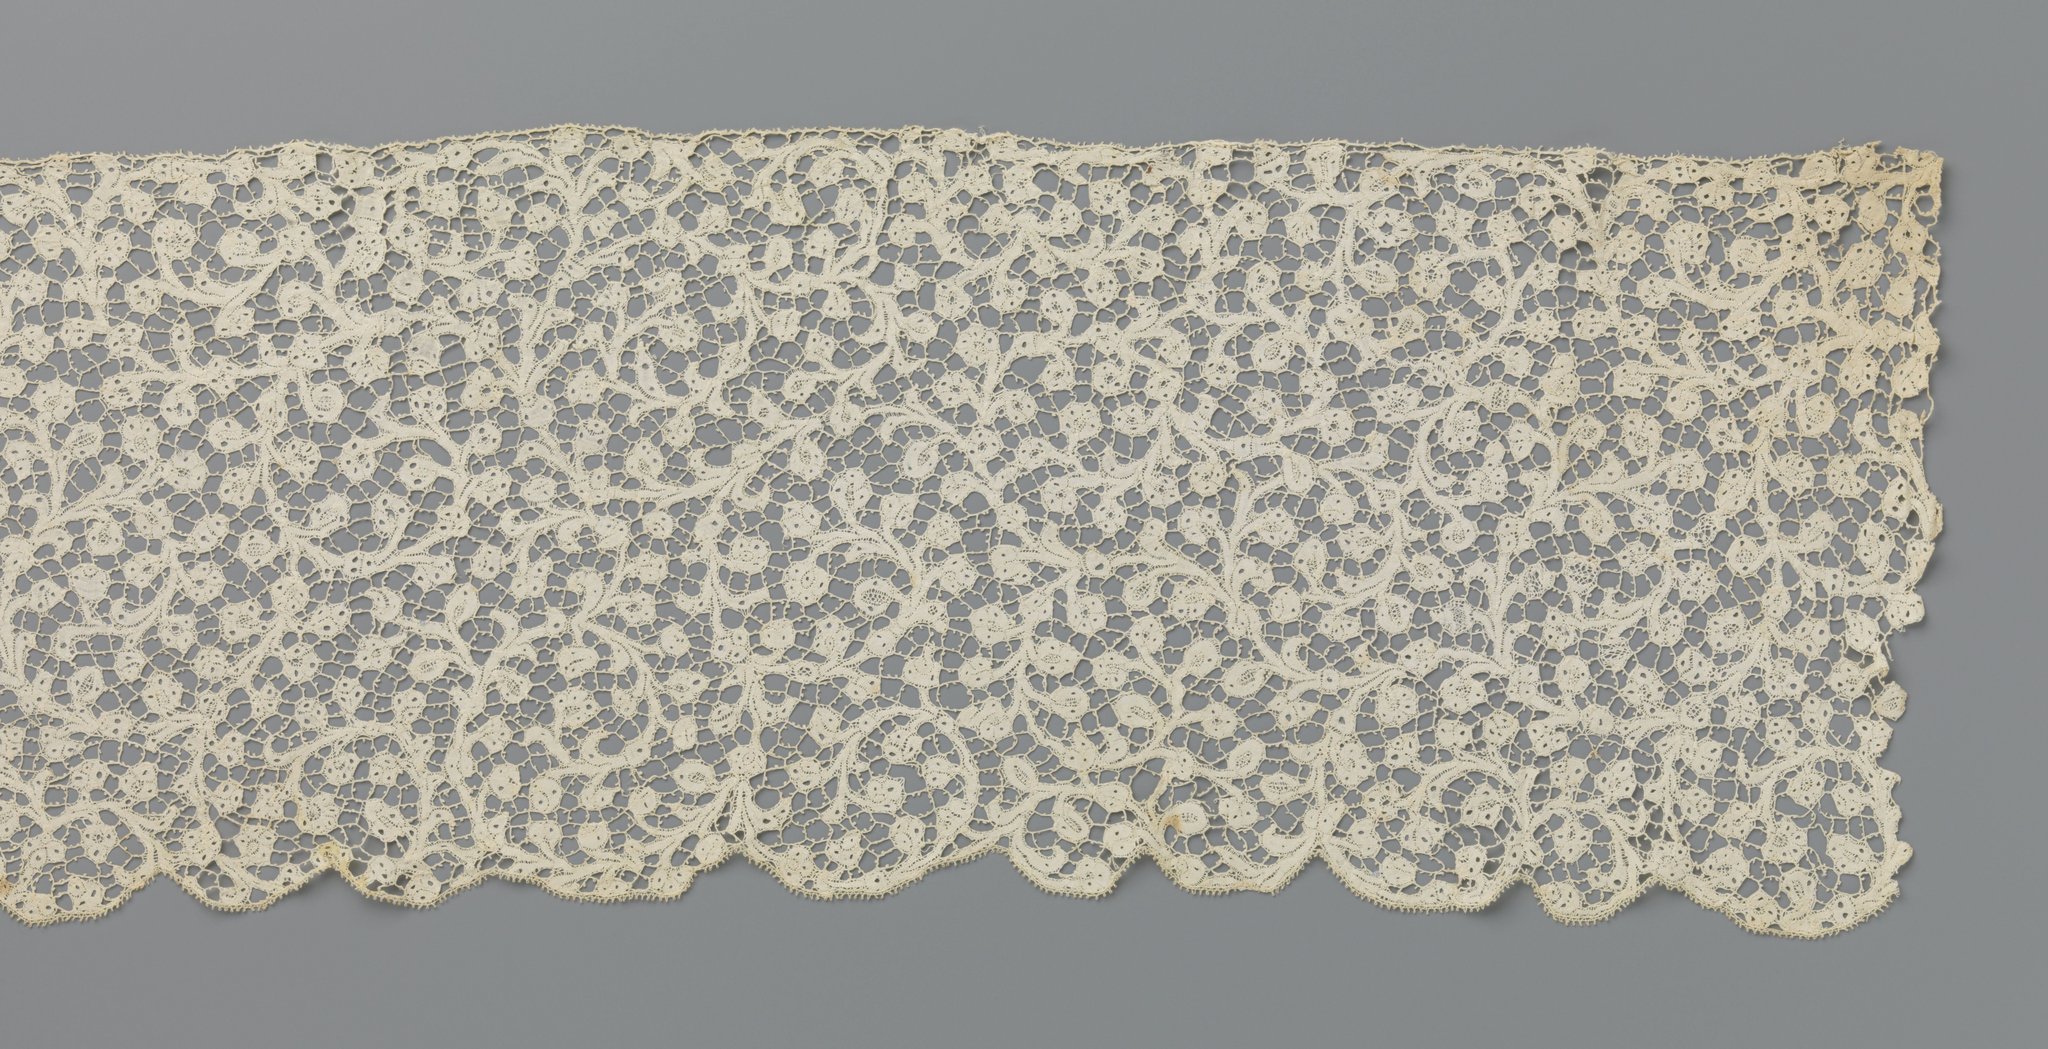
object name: strip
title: Strook kloskant met voluutranken en ronde bloempjes aan omkrullende zijtakken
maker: Anonymous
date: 1685-1699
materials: linen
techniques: lace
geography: southern netherlands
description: Strook naturelkleurige kloskant, oudvlaamse kant. Het patroon bestaat uit een wirwar van voluutranken met talrijke omkrullende zijtakken met kleine merendeels ronde of ovaalvormige bloemen en blaadjes. De motieven zijn met elkaar verbonden door een gepicoteerde vlechtengrond. De motieven zijn gemaakt in linnenslag met uitparingen en opengewerkte randjes. De onregelmatige schulpen langs de onderzijde volgen de rondingen van de voluutranken en zijn afgewerkt met picots. De bovenzijde is recht afgewerkt en ook voorzien van picots.